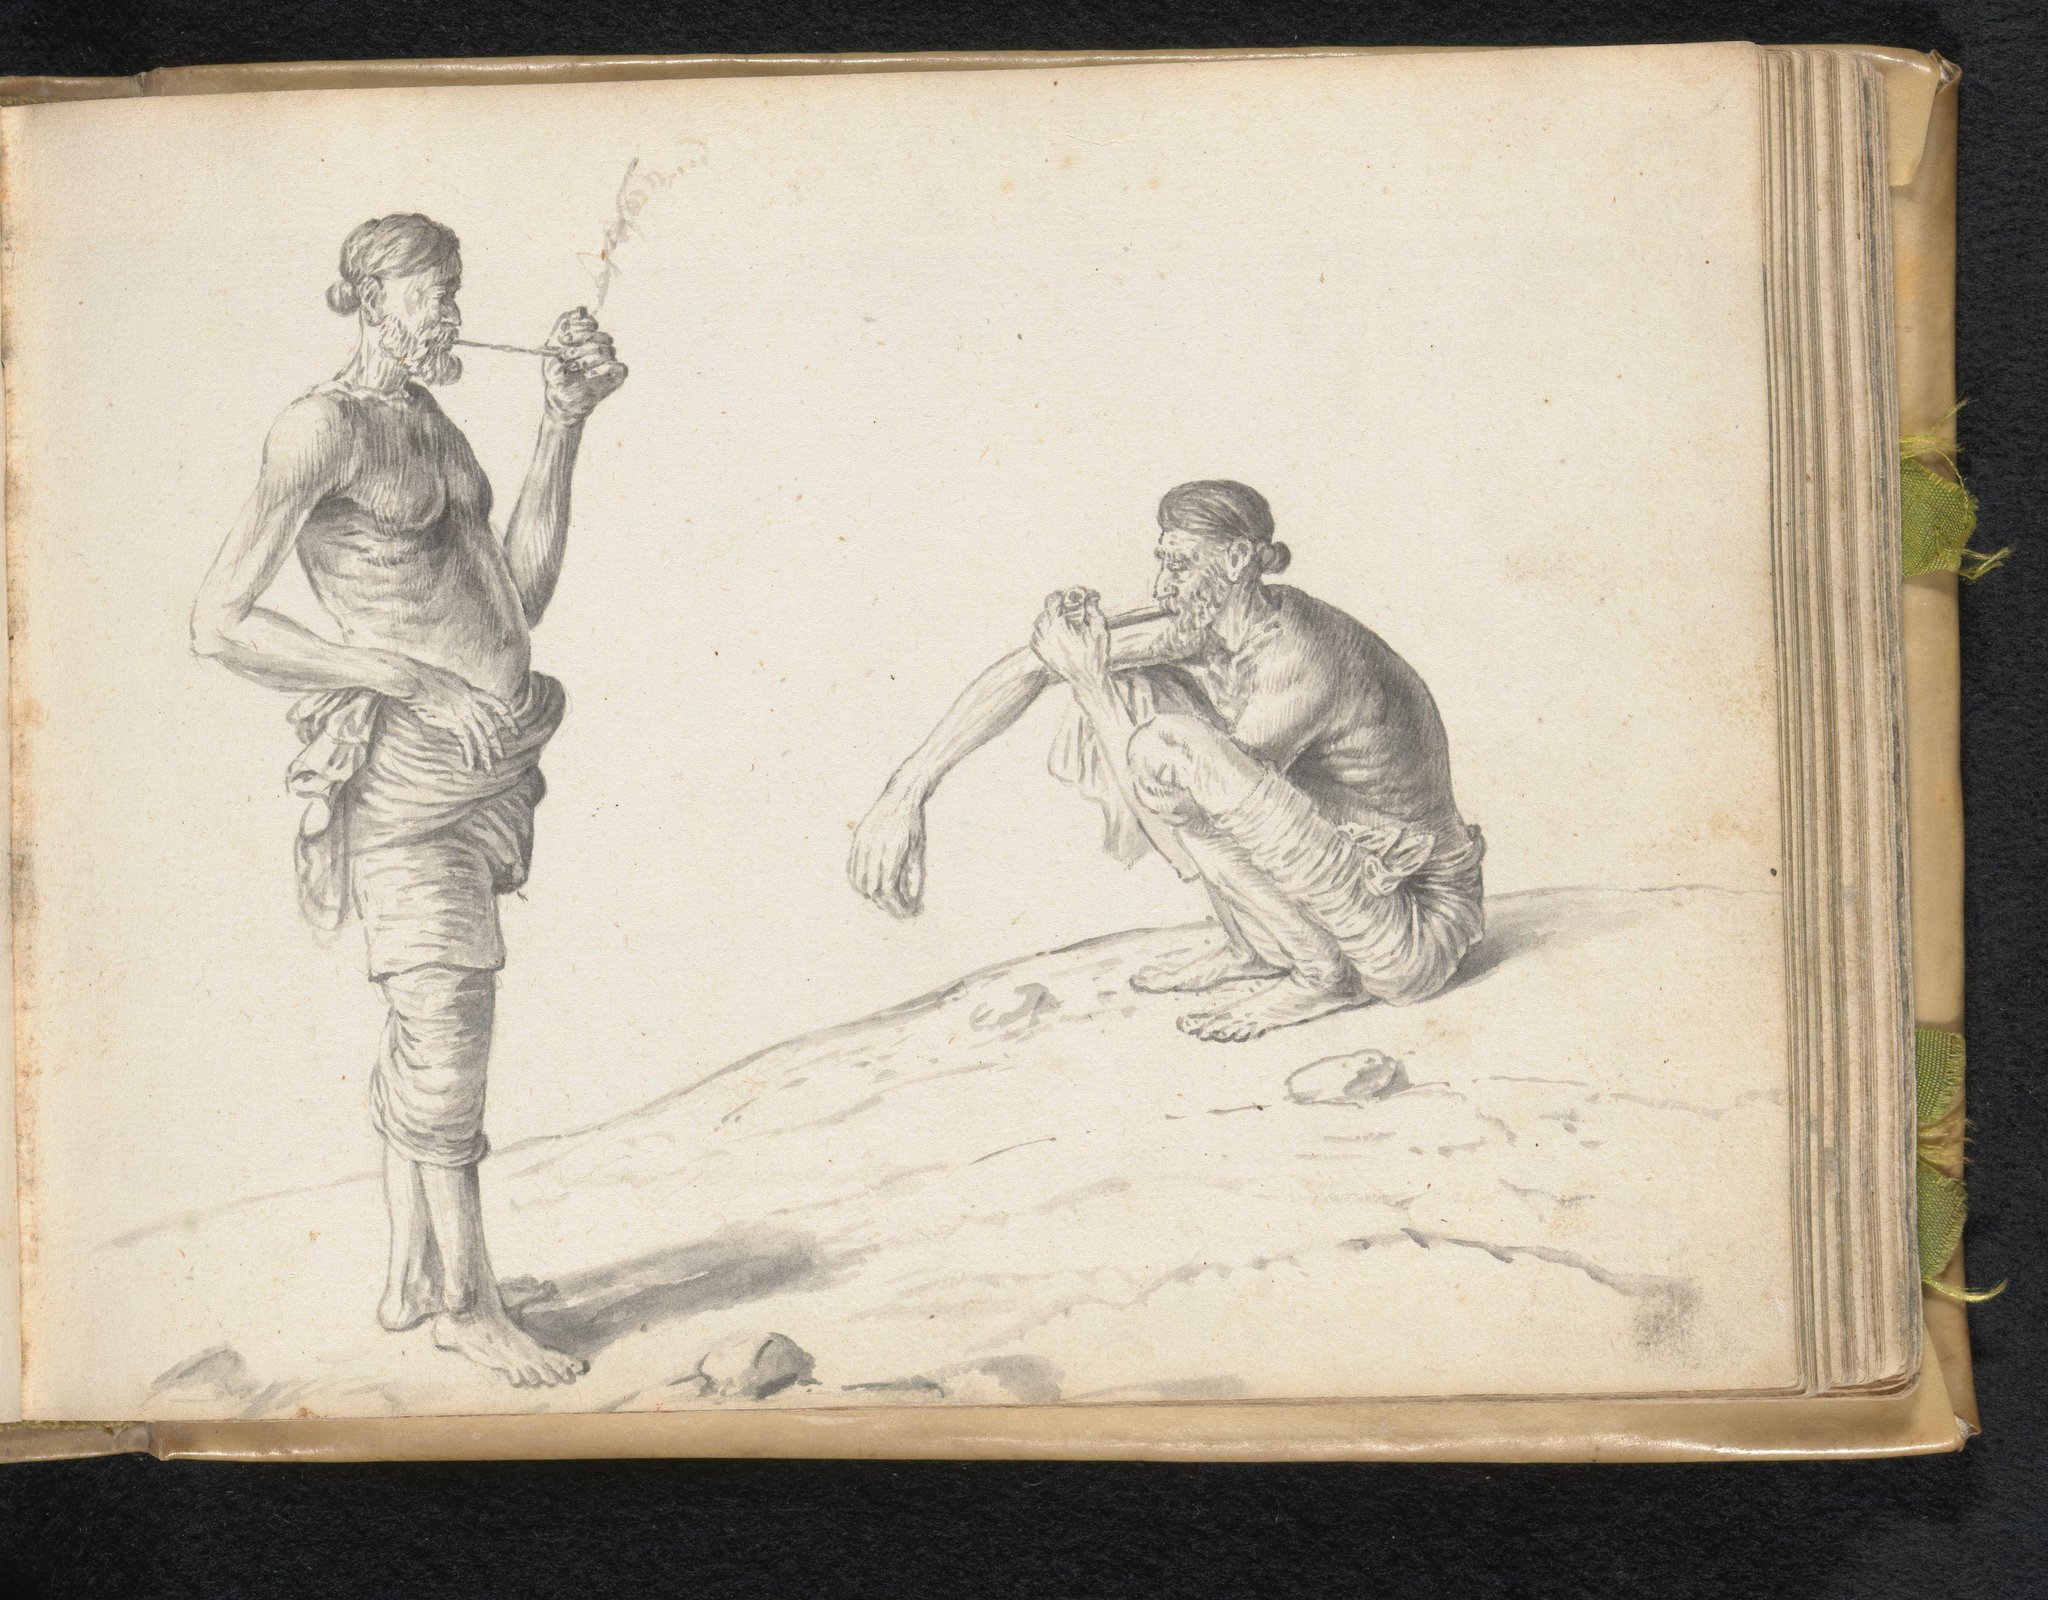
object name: sketchbook leaf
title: Two men smoking a pipe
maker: esaias boursse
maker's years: 1631-1672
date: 1662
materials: ink, paper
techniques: brush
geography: sri lanka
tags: asiatic races and peoples (with name), 41d232(...) skirt (lungi), pipe ~ tobacco, sri lanka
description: Buiten op een hellend terrein zijn twee pijprokende mannen te zien. De man links staat, de man rechts zit gehurkt. Beiden dragen een heupdoek (veshti, lungi) tot over de knie, omgewikkeld en vastgestoken in de taille, Het bovenlijf is onbedekt. Beide mannen hebben hun haar naar achter gekamd en vastgestoken in een knot, en een volle baard en snor. De staande figuur houdt de kop vast van een langstelige goudse pijp waaraan hij trekt met zijn mond. Een wolkje rook kringelt boven zijn vingers omhoog. Ook de gehurkte man trekt aan een goudse pijp, waarvan hij de kop vast houdt met zijn linkerhand. Mogelijk heeft de tekenaar dezelfde man dubbel laten poseren. Gezien de haardracht en gezichtsbeharing zijn het waarschijnlijk Singalese mannen. Blad 48 uit een schetsboek met 117 bladen.